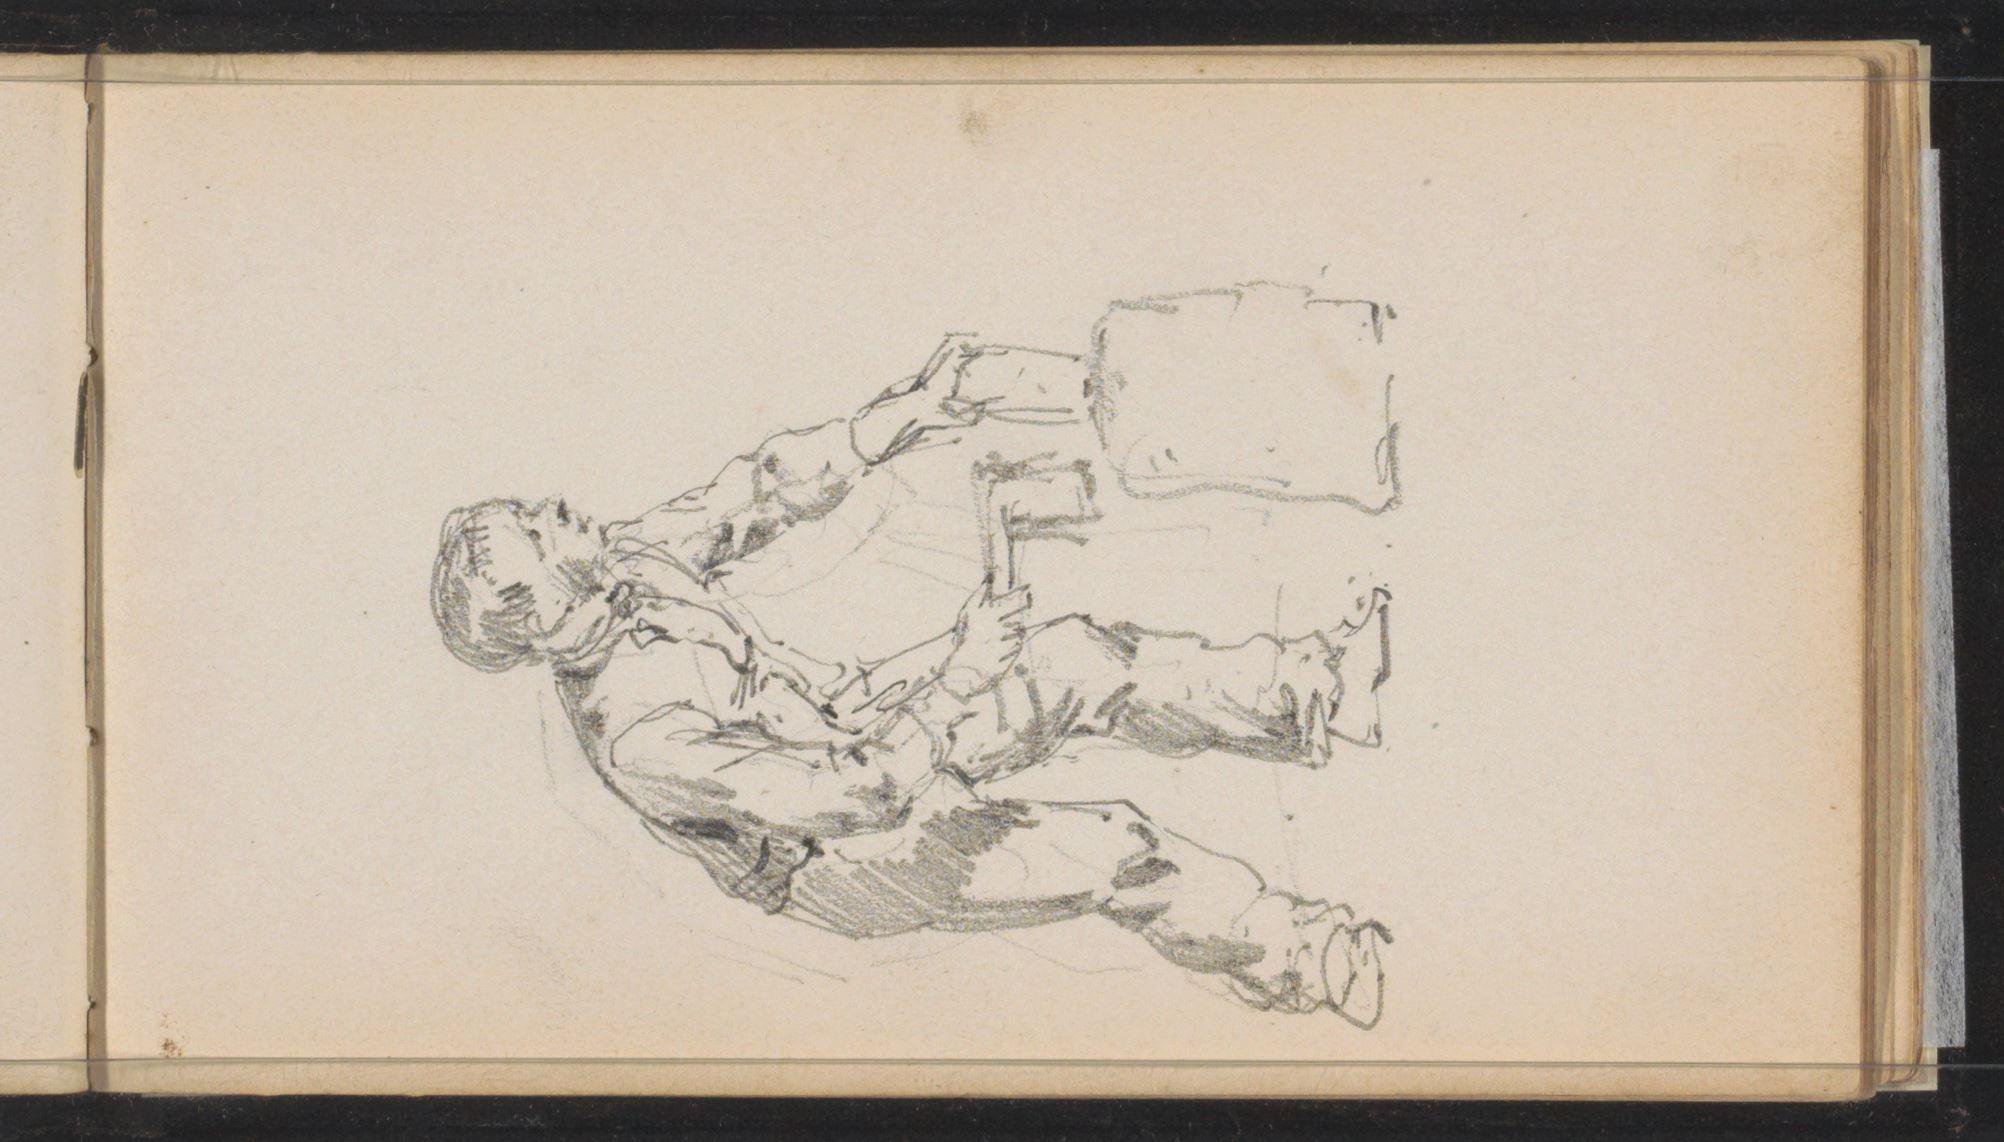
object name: sketchbook leaf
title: Houthakkende man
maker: cornelis springer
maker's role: draughtsman, painter, print maker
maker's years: 1817-1891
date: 1860-1866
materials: paper, pencil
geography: netherlands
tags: woodcutting, woodcutter ~ forestry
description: Houthakkende man. Blad 26 uit een schetsboek met 44 bladen.